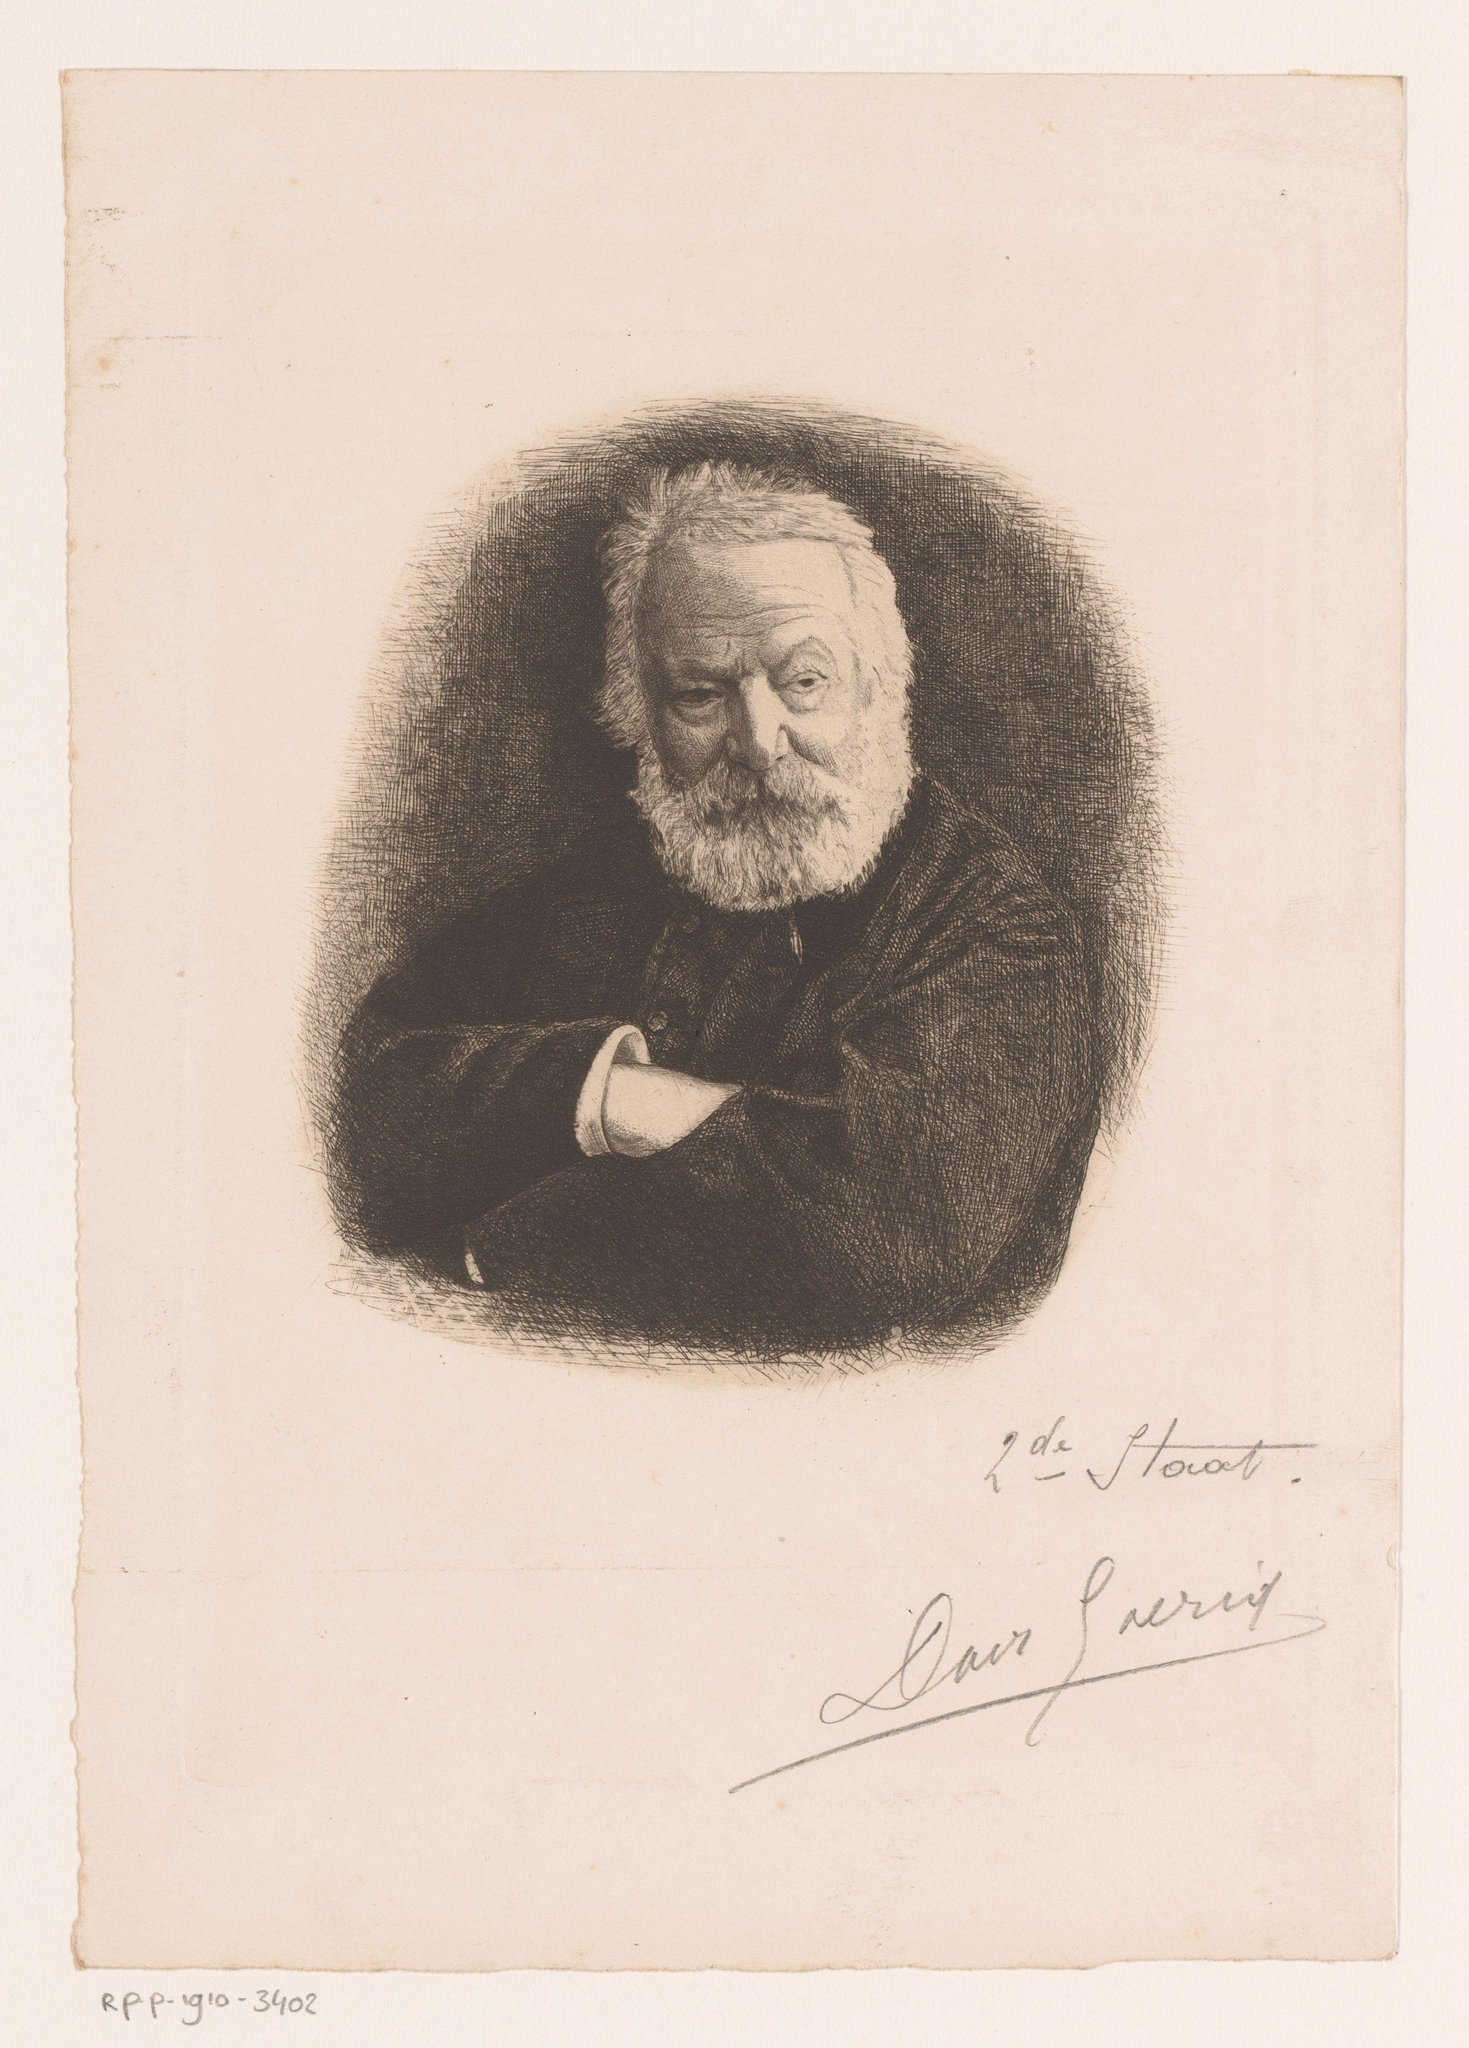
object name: print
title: Portret van Victor Hugo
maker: david goerig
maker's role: print maker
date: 1850-1899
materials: paper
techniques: etching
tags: paris, victor hugo, historical persons, old man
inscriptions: inscription: ‘2de Staat’, collector's mark: Lugt 2228